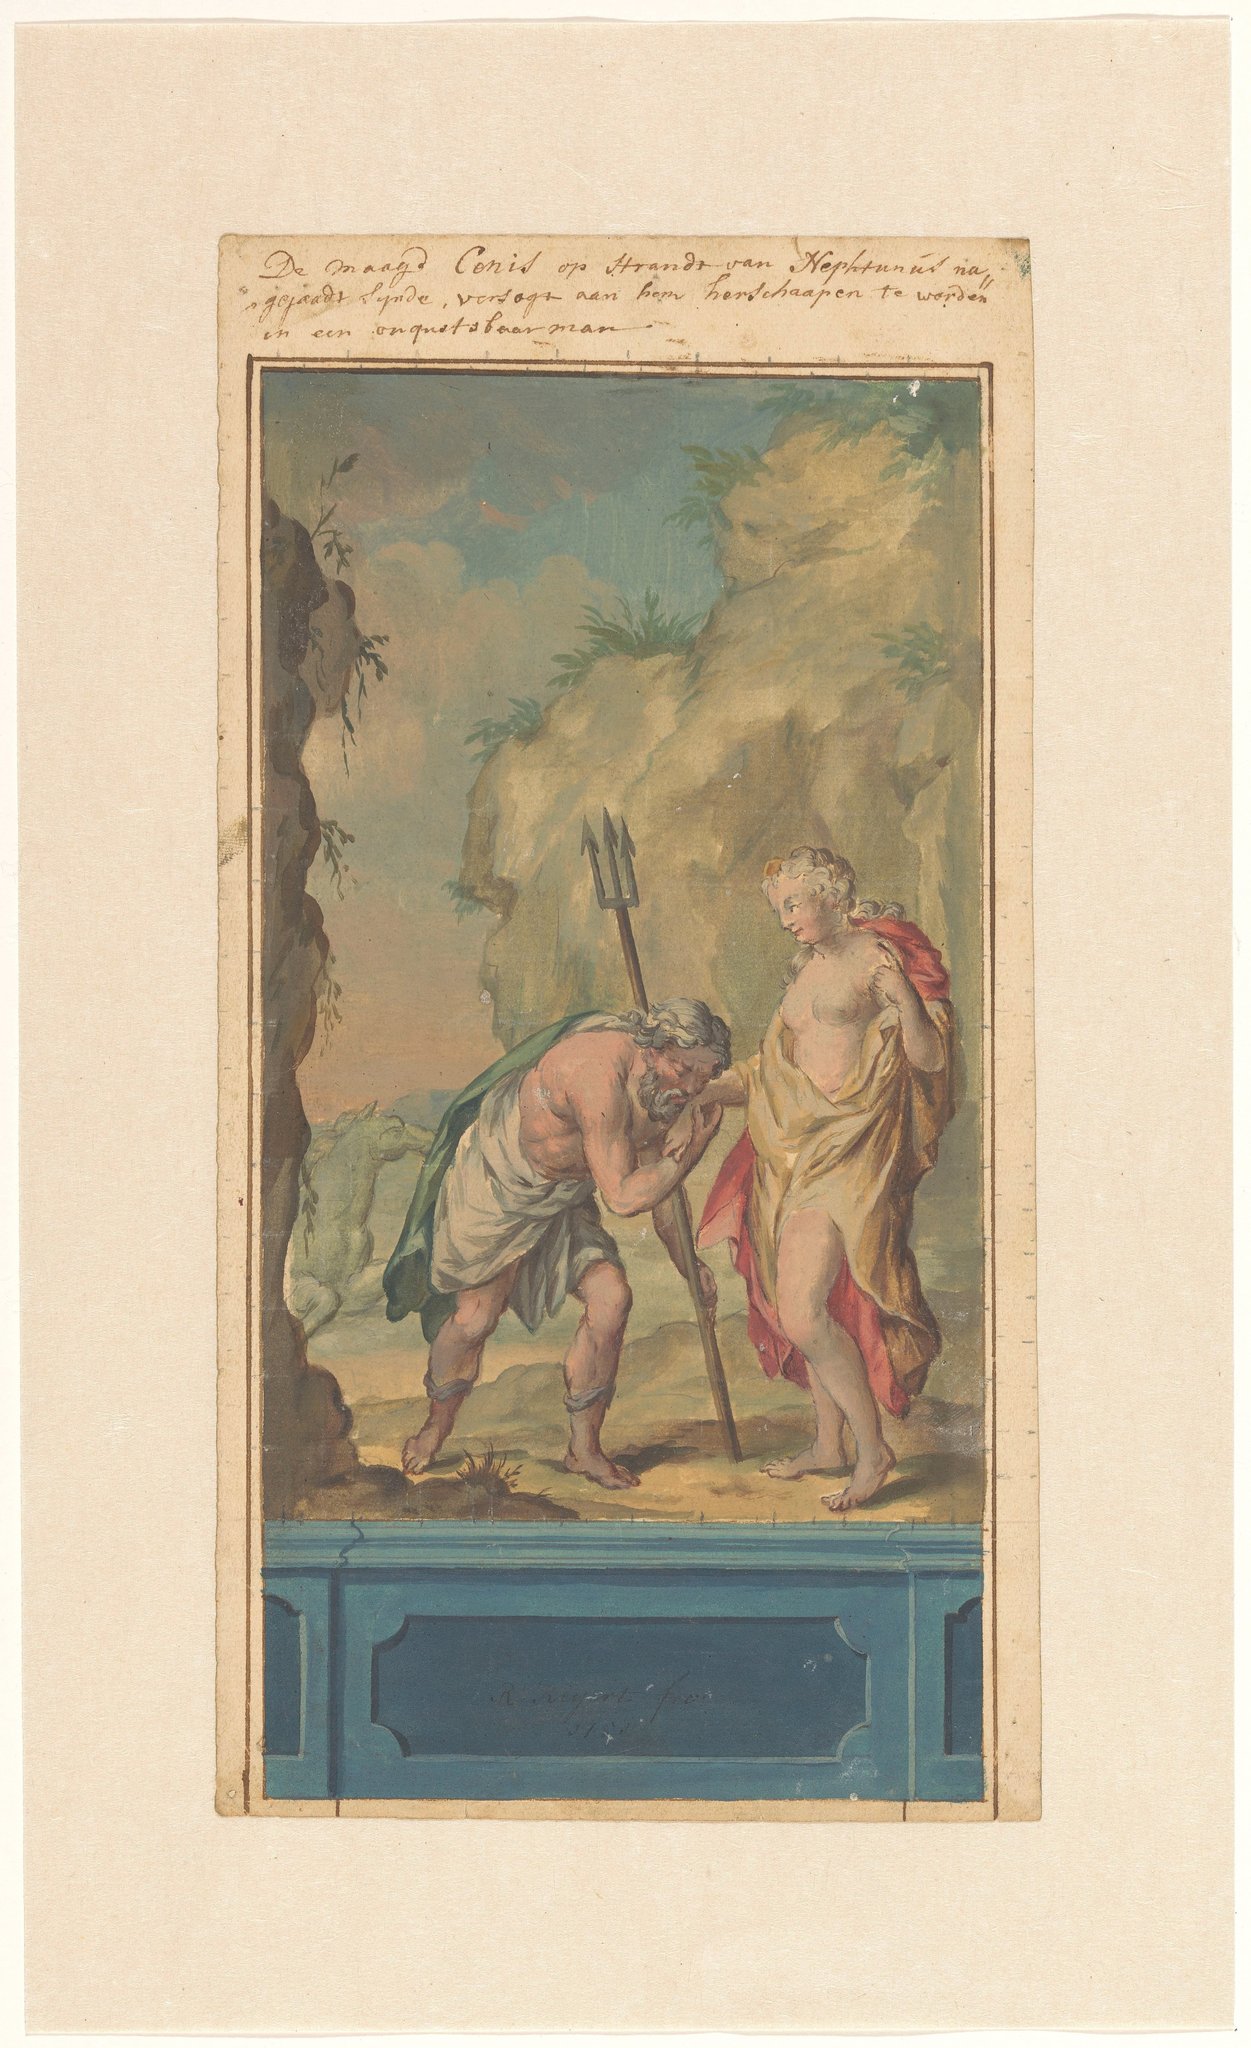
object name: design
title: Ontwerp voor een behangschildering met Neptunus en Coronis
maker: rienk keyert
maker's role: draughtsman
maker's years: 1709-1775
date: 1751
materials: paper, watercolor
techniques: brush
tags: (story of) neptune (poseidon)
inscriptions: date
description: Behoort tot hetzelfde decoratieproject als inv. RP-T-1906-10.